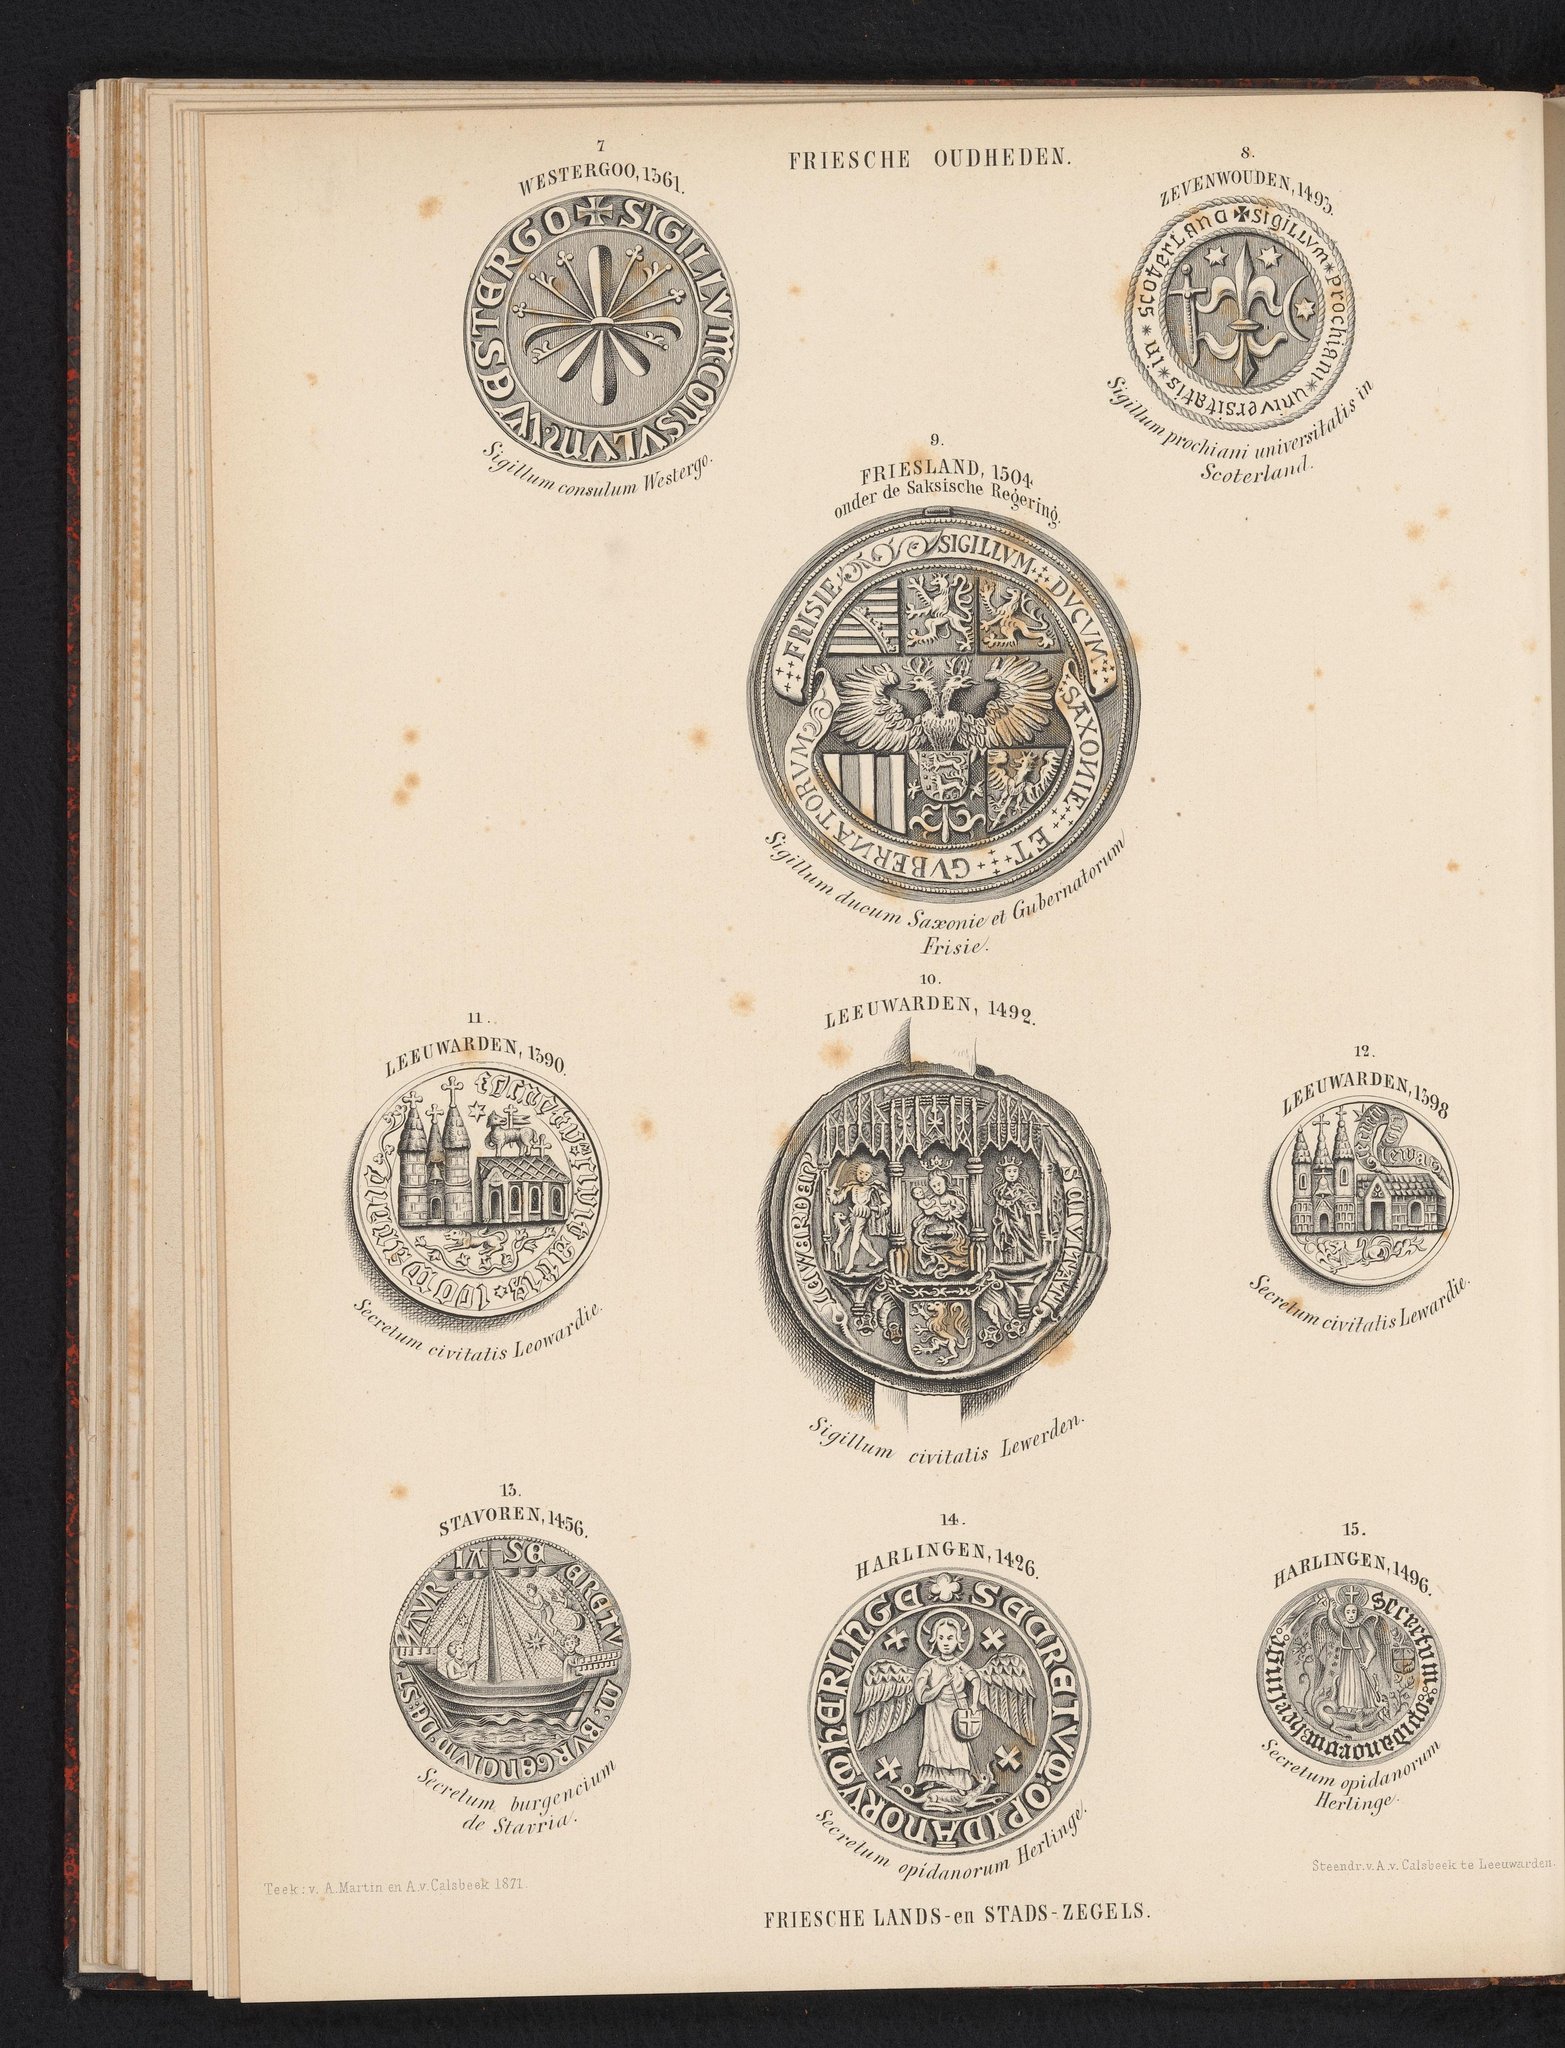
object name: historical object representation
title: Oude Friese zegels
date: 1871-1875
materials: paper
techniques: lithograph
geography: leeuwarden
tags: seal, stamp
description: Illustratie in: Friesche Oudheden. Afbeeldingen van merkwaardige voorwerpen van Wetenschap en Kunst, gevonden in de archieven, kerken, kasteelen, terpen enz. van Friesland, Leeuwarden 1875. Niet in Frederik Muller; door het RPK toegevoegd nummer.